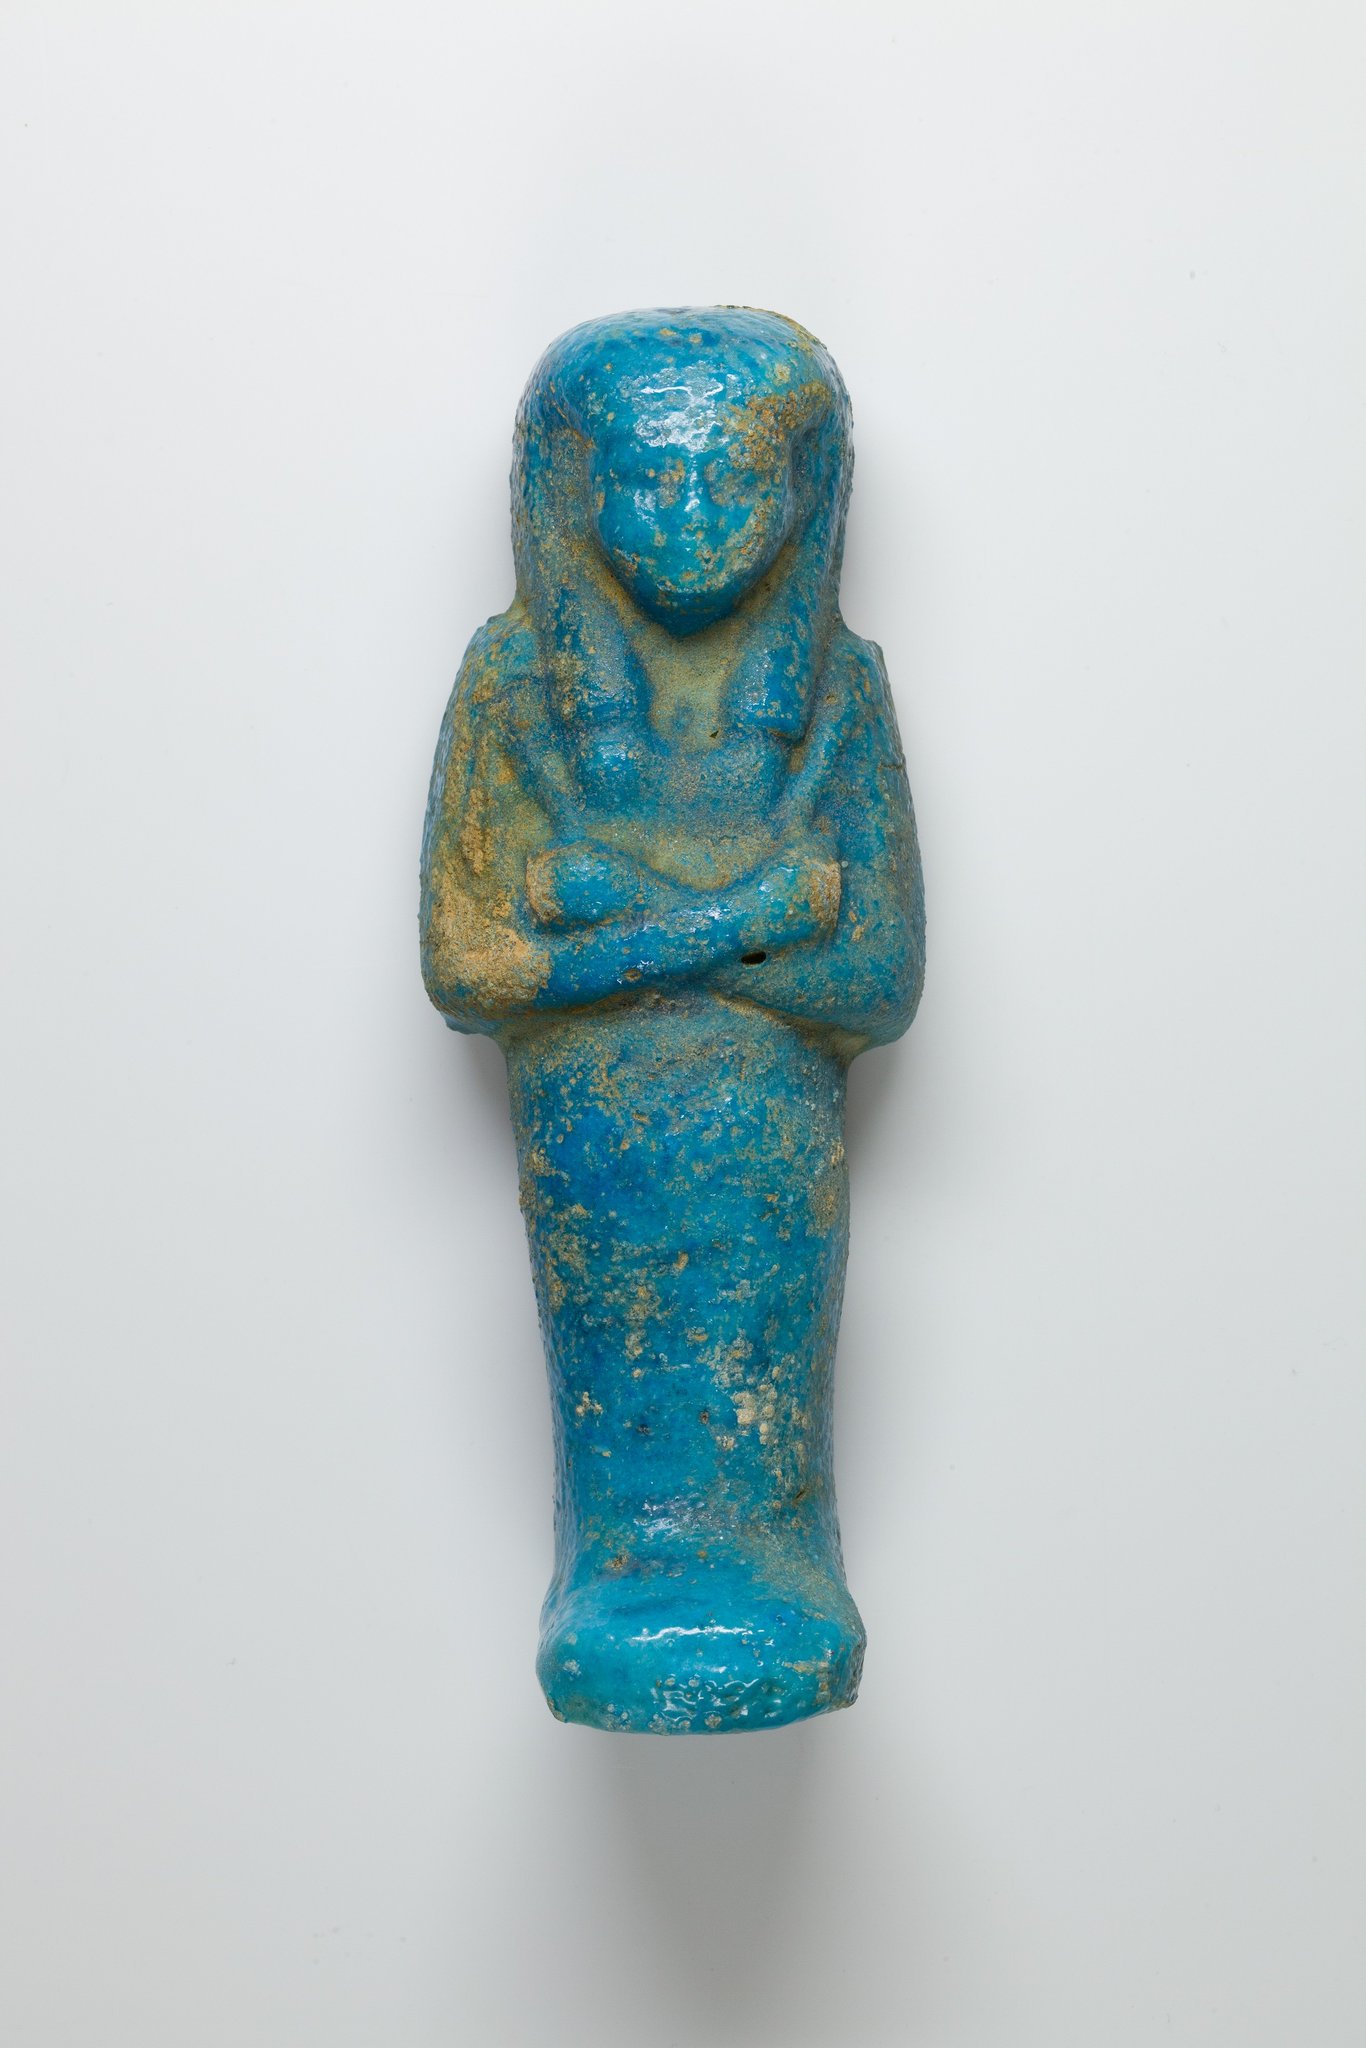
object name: worker shabti, henettawy c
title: Worker Shabti of Henettawy (C), Daughter of Isetemkheb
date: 990-970 BCE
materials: faience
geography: egypt